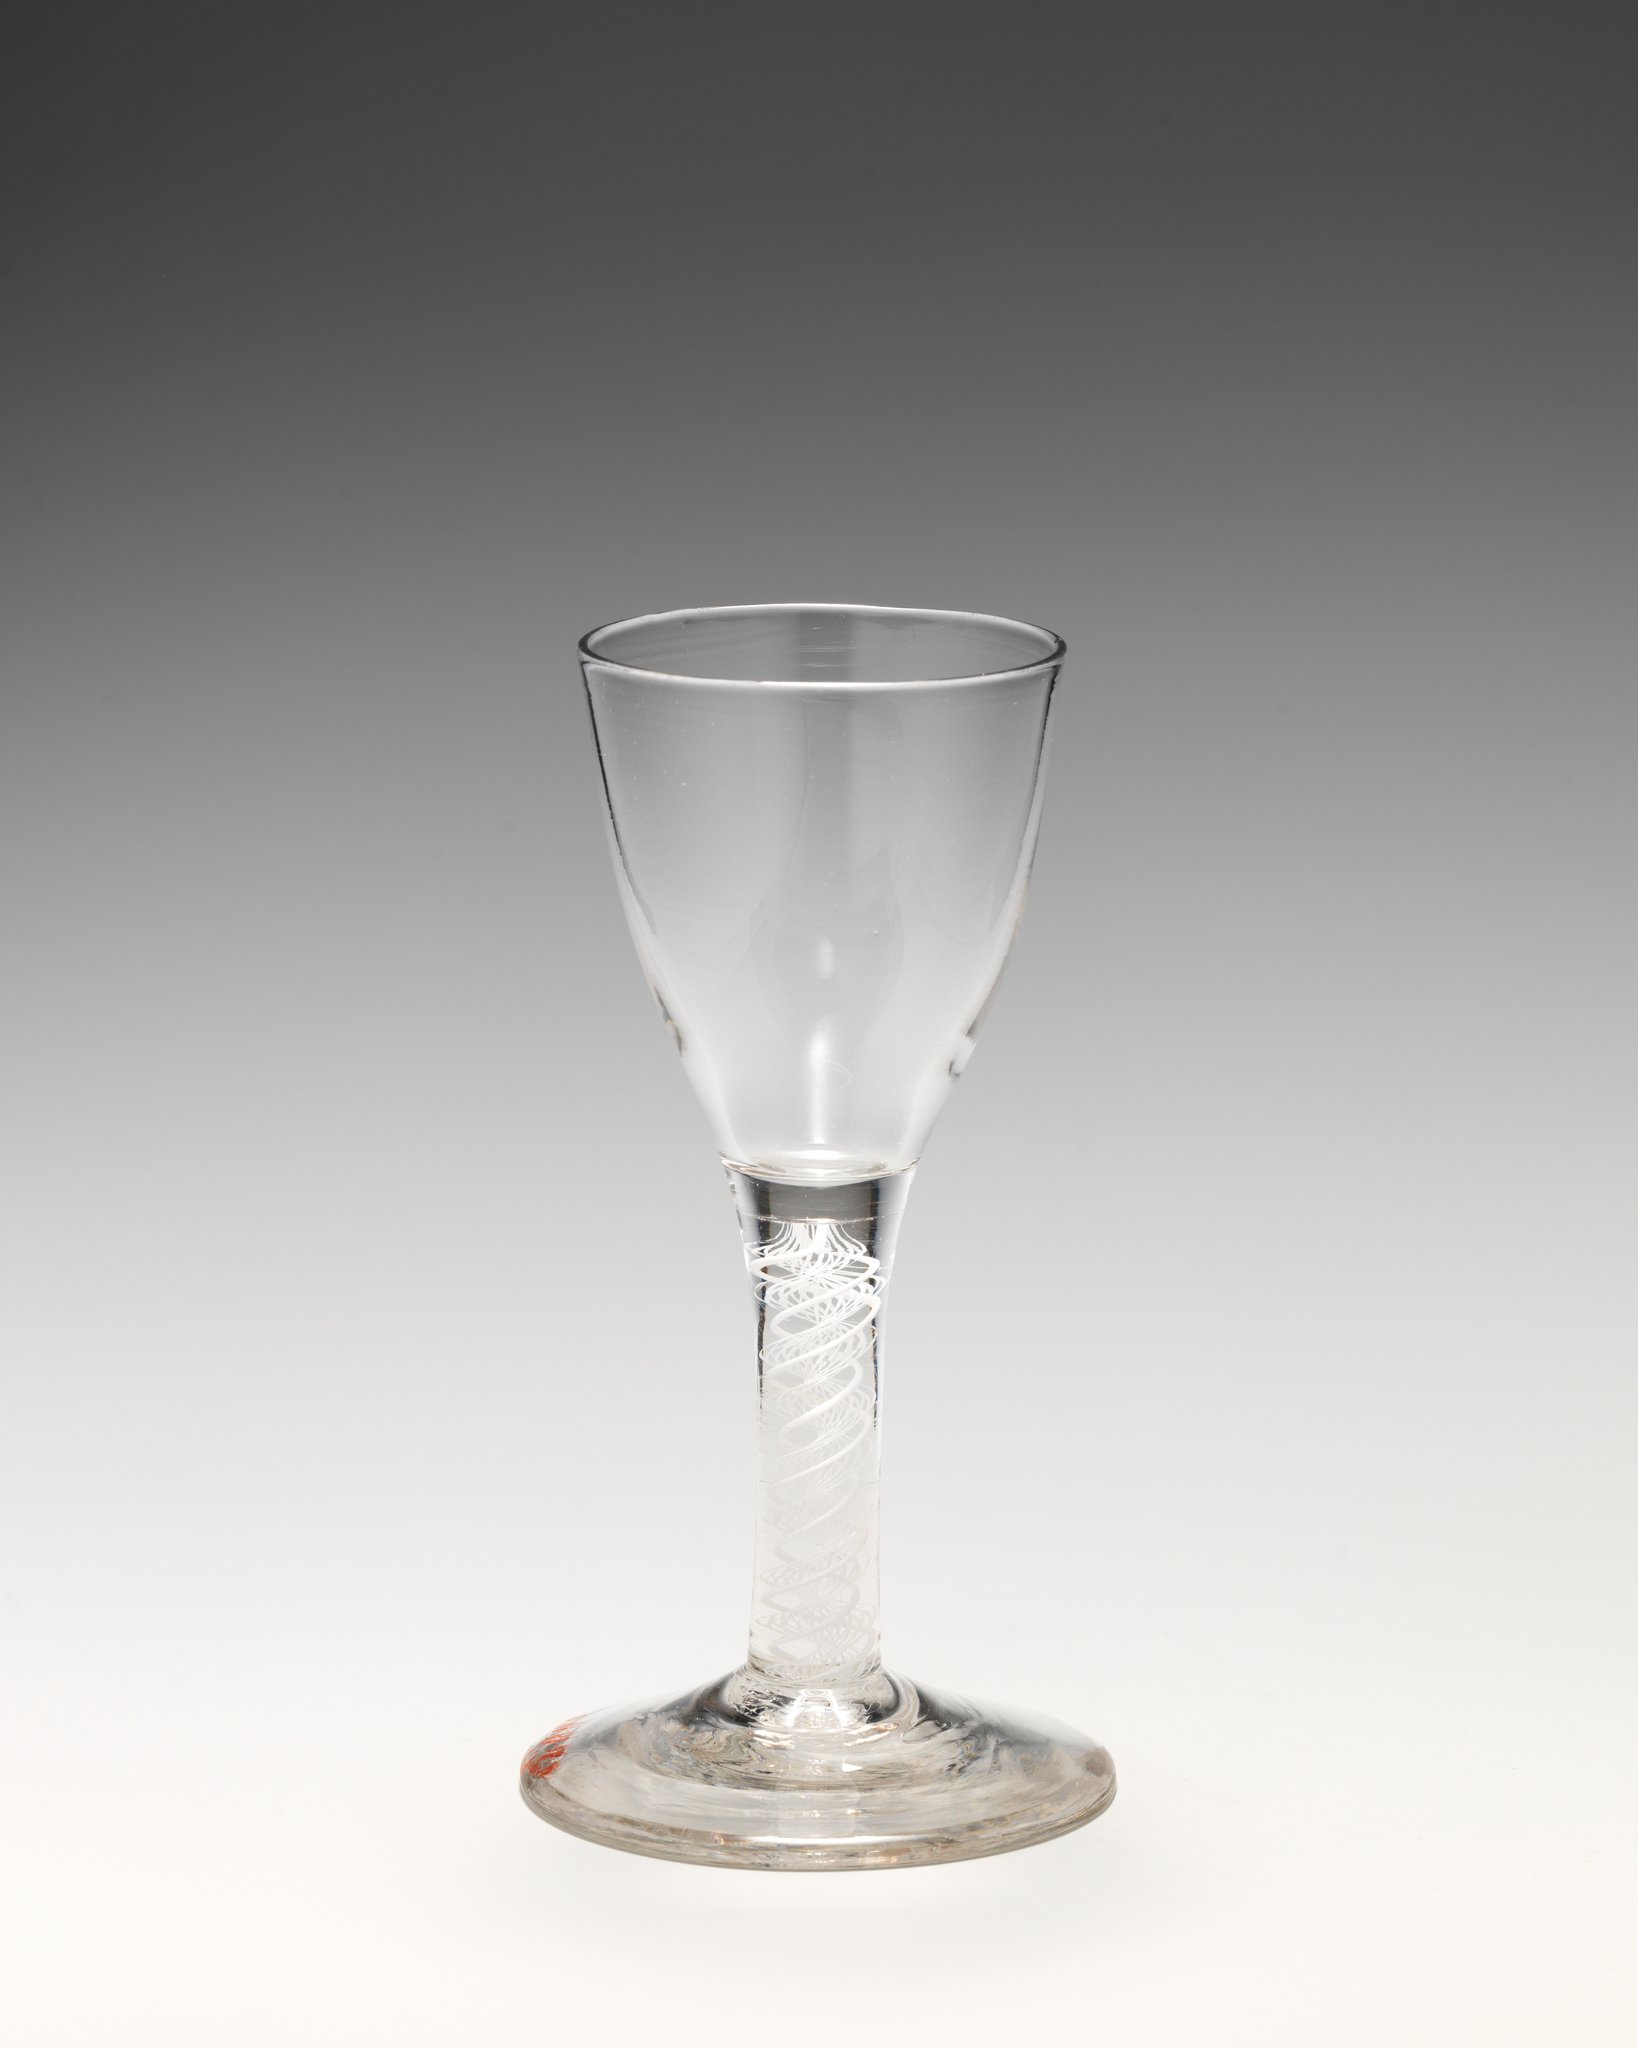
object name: wineglass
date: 1750-1800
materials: glass